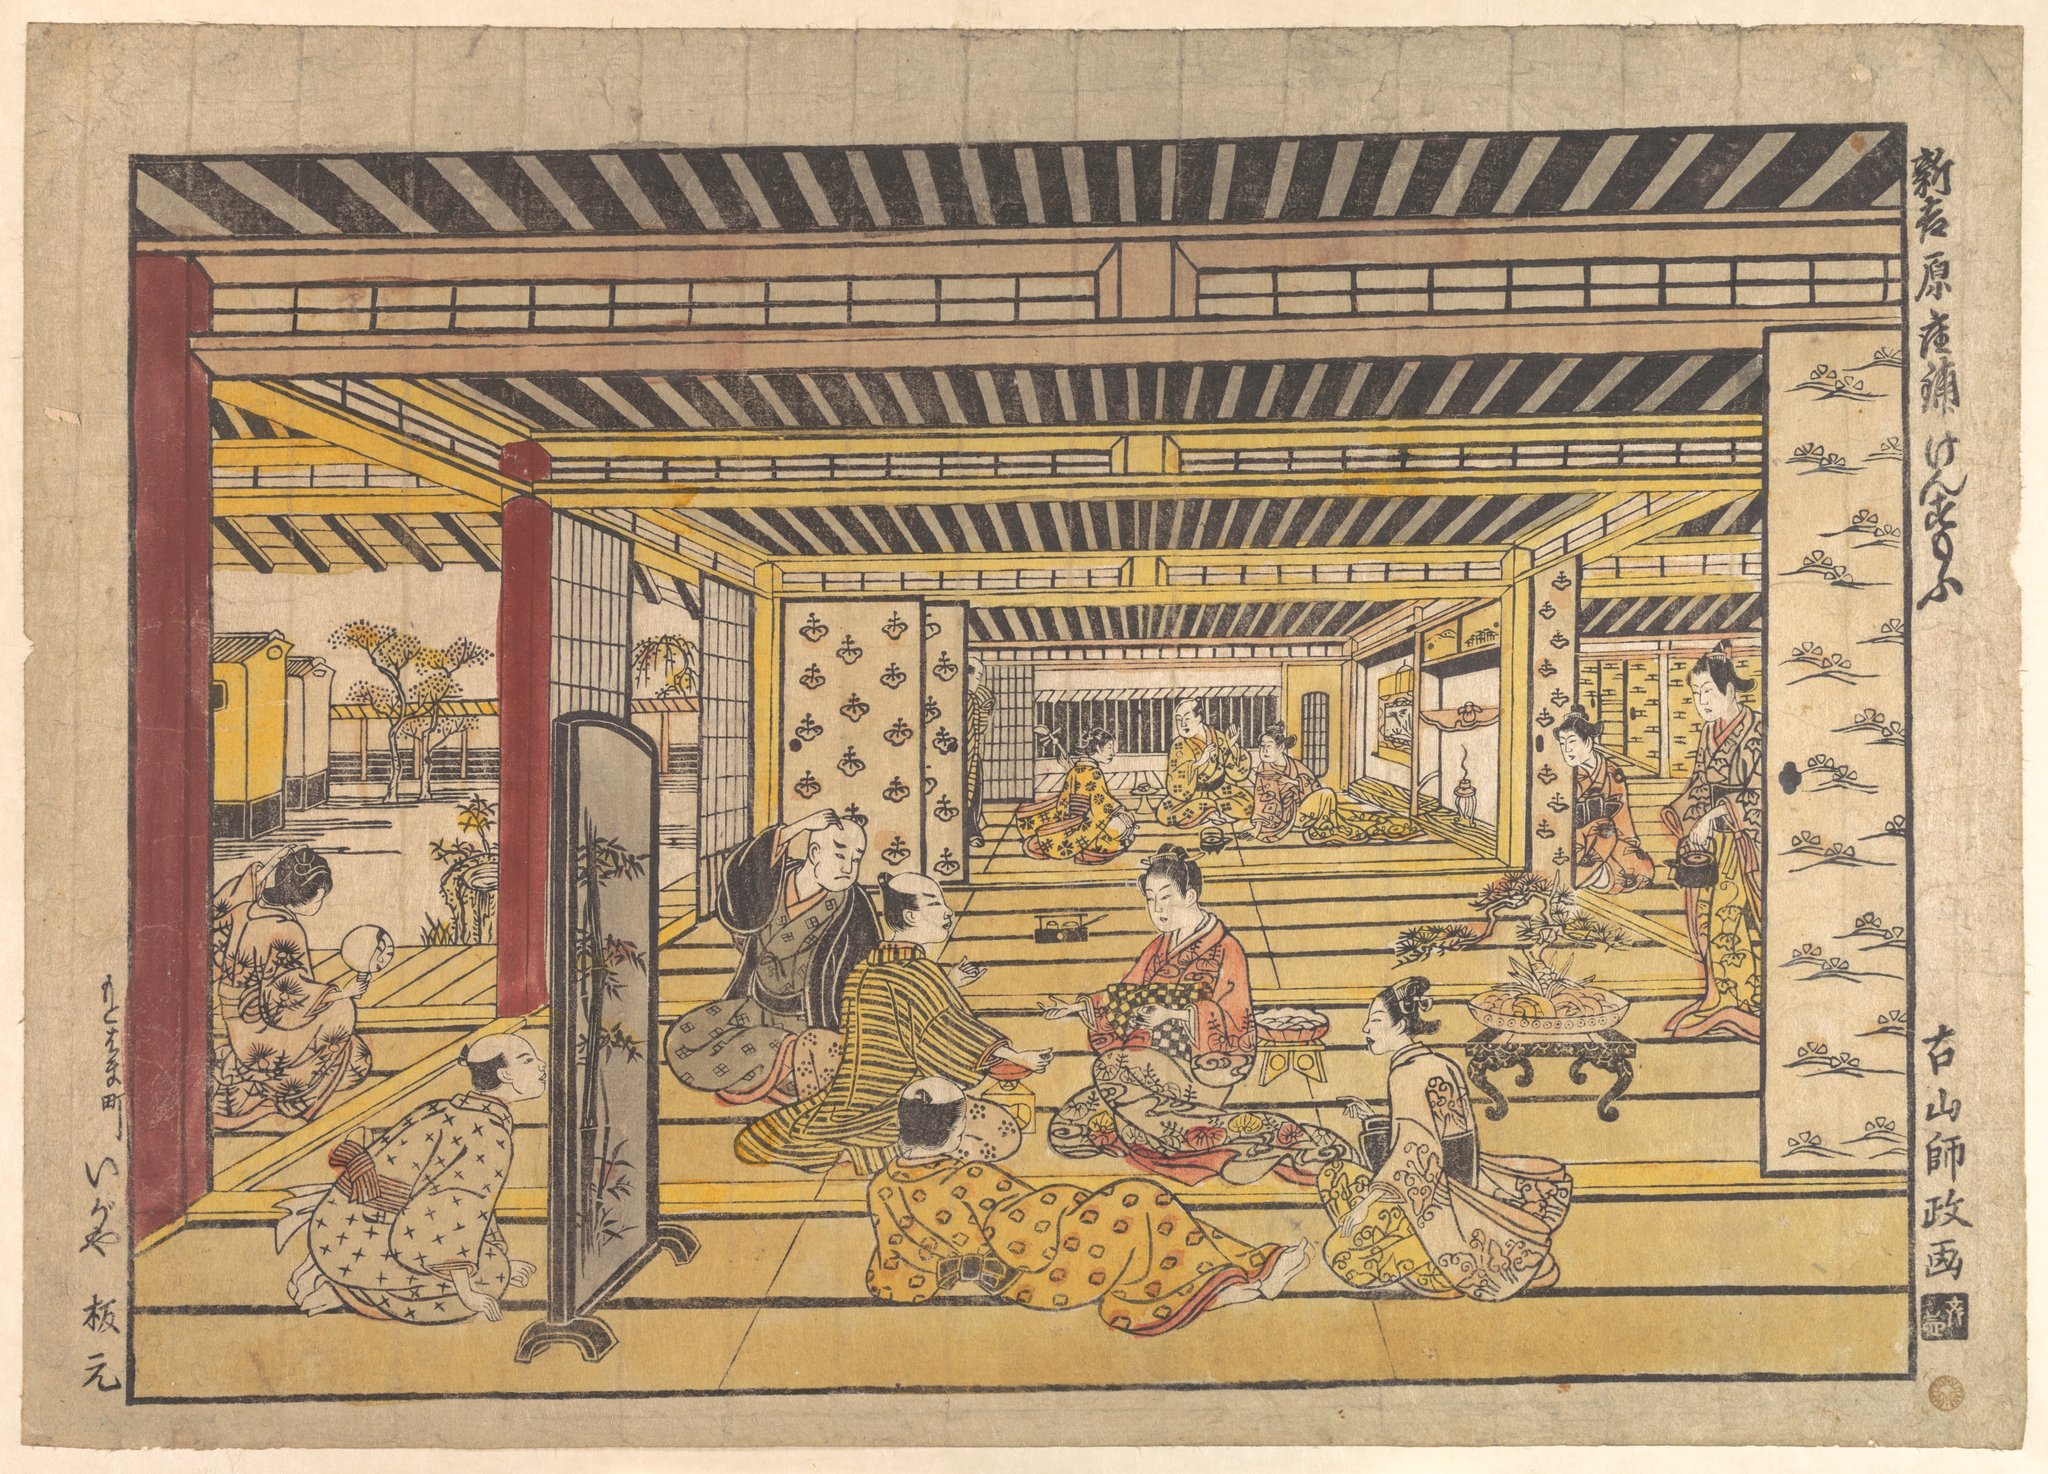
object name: woodblock print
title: A Game of Hand Sumo in the New Yoshiwara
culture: japanese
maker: furuyama moromasa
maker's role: artist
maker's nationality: japanese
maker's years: 1712-1772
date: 1740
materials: ink, paper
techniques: woodblock print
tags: interiors,men,women,mirrors